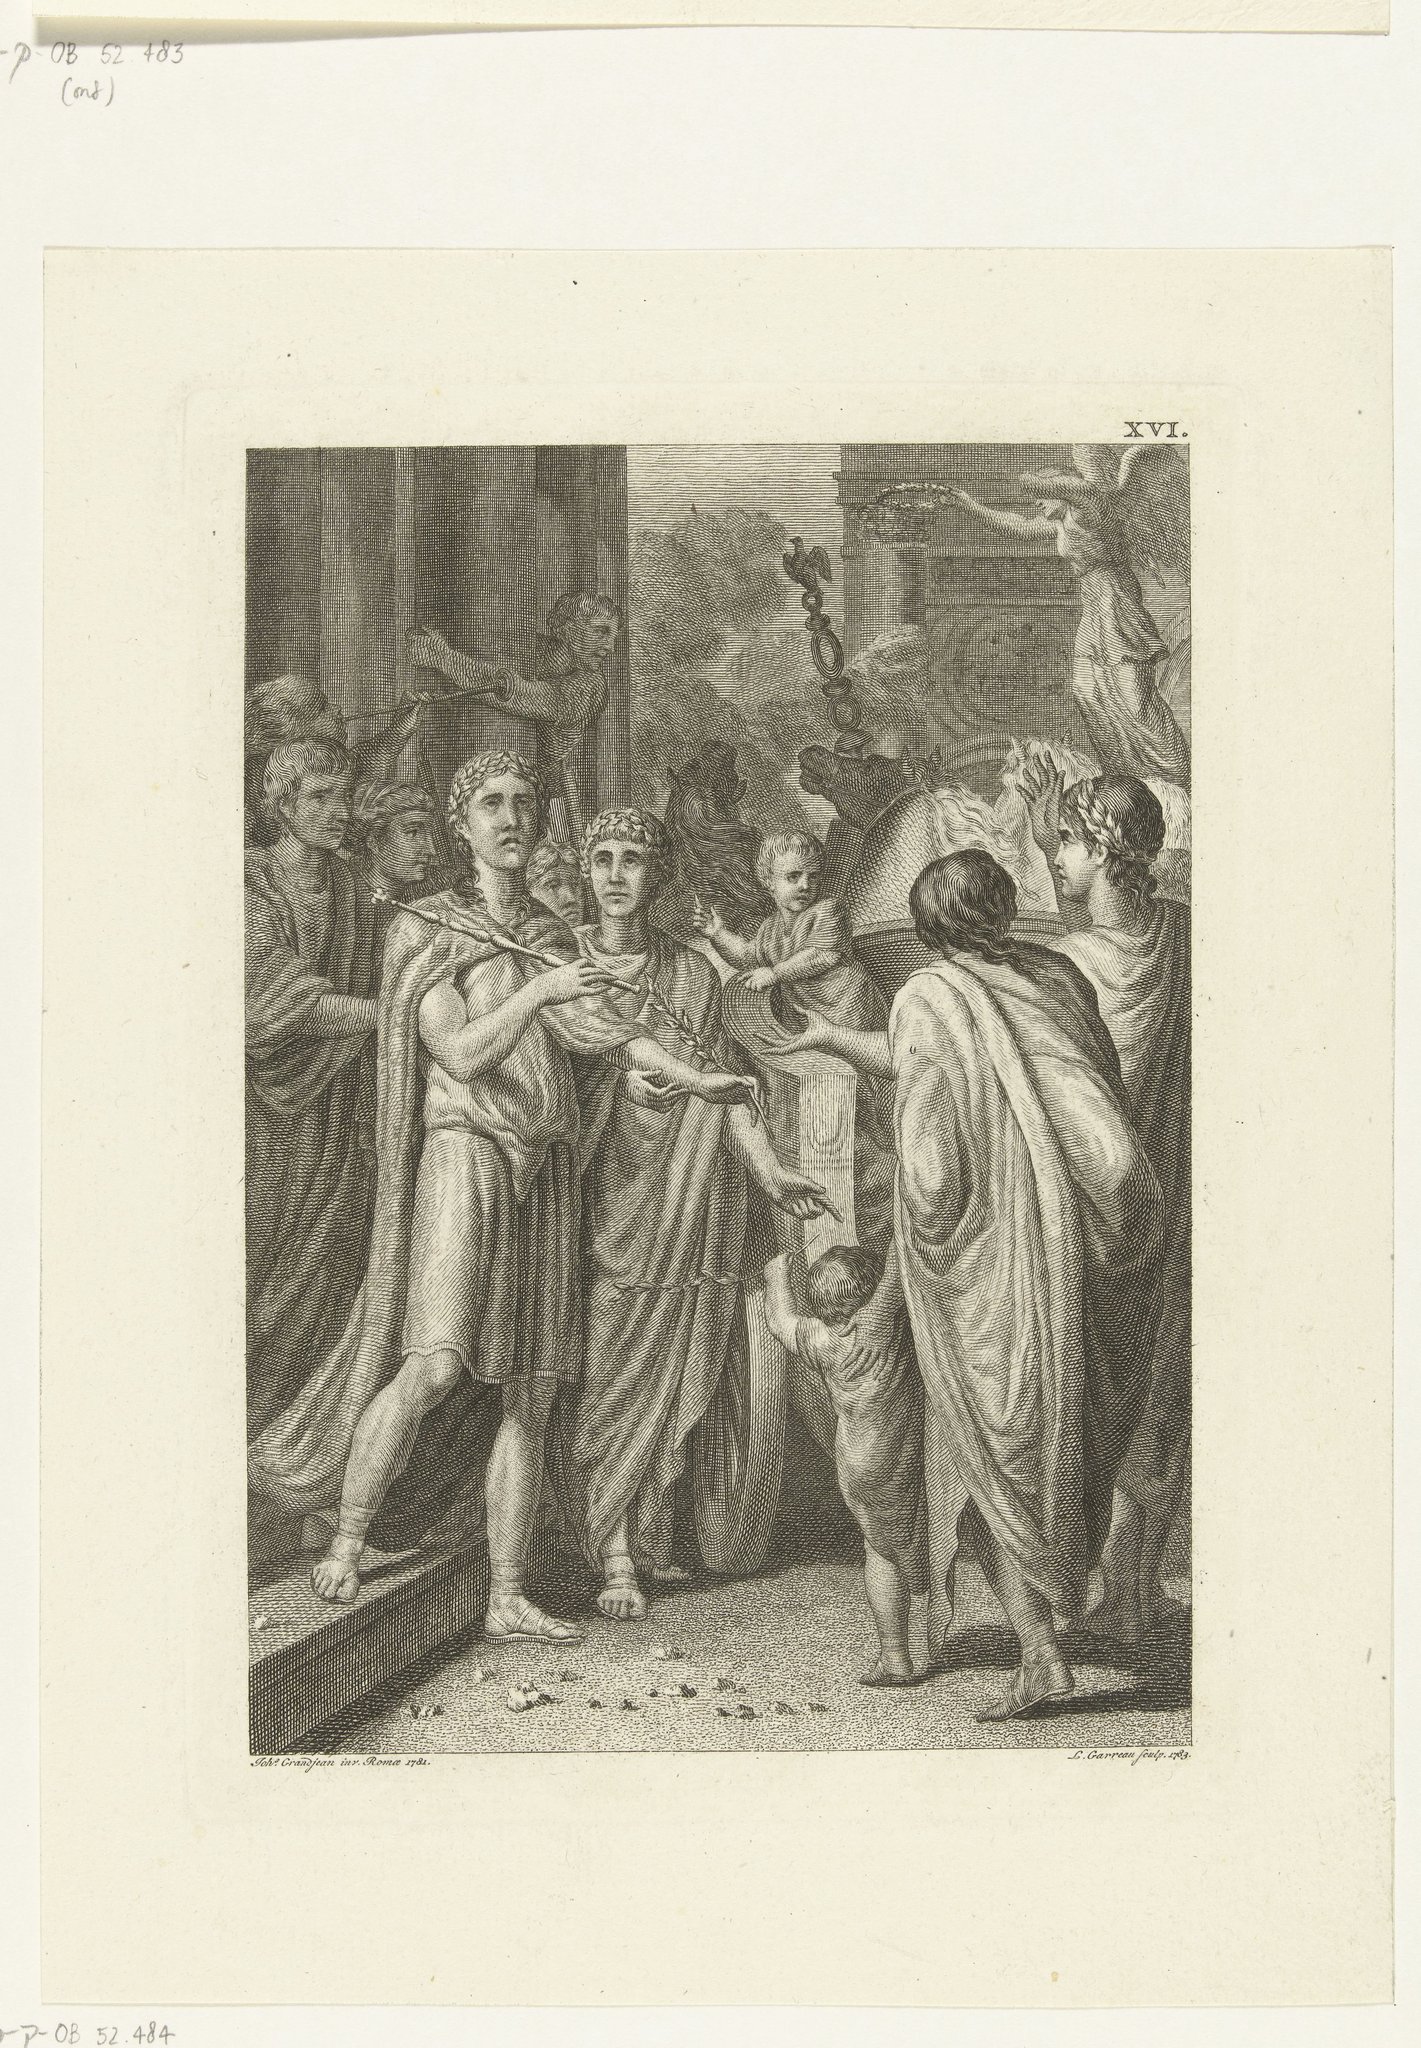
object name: print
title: Triomftocht van Germanicus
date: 1783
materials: paper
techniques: engraving, etching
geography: amsterdam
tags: conqueror triumphing, triumphal entry of victor, netherlands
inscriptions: collector's mark: Lugt 2228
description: De triomftocht van Germanicus in Rome. Tijdens deze intrede wordt Germanicus herenigd met zijn zonen, die hij al tijden niet heeft gezien. De prent is een deel van de geschiedenis van generaal Germanicus.